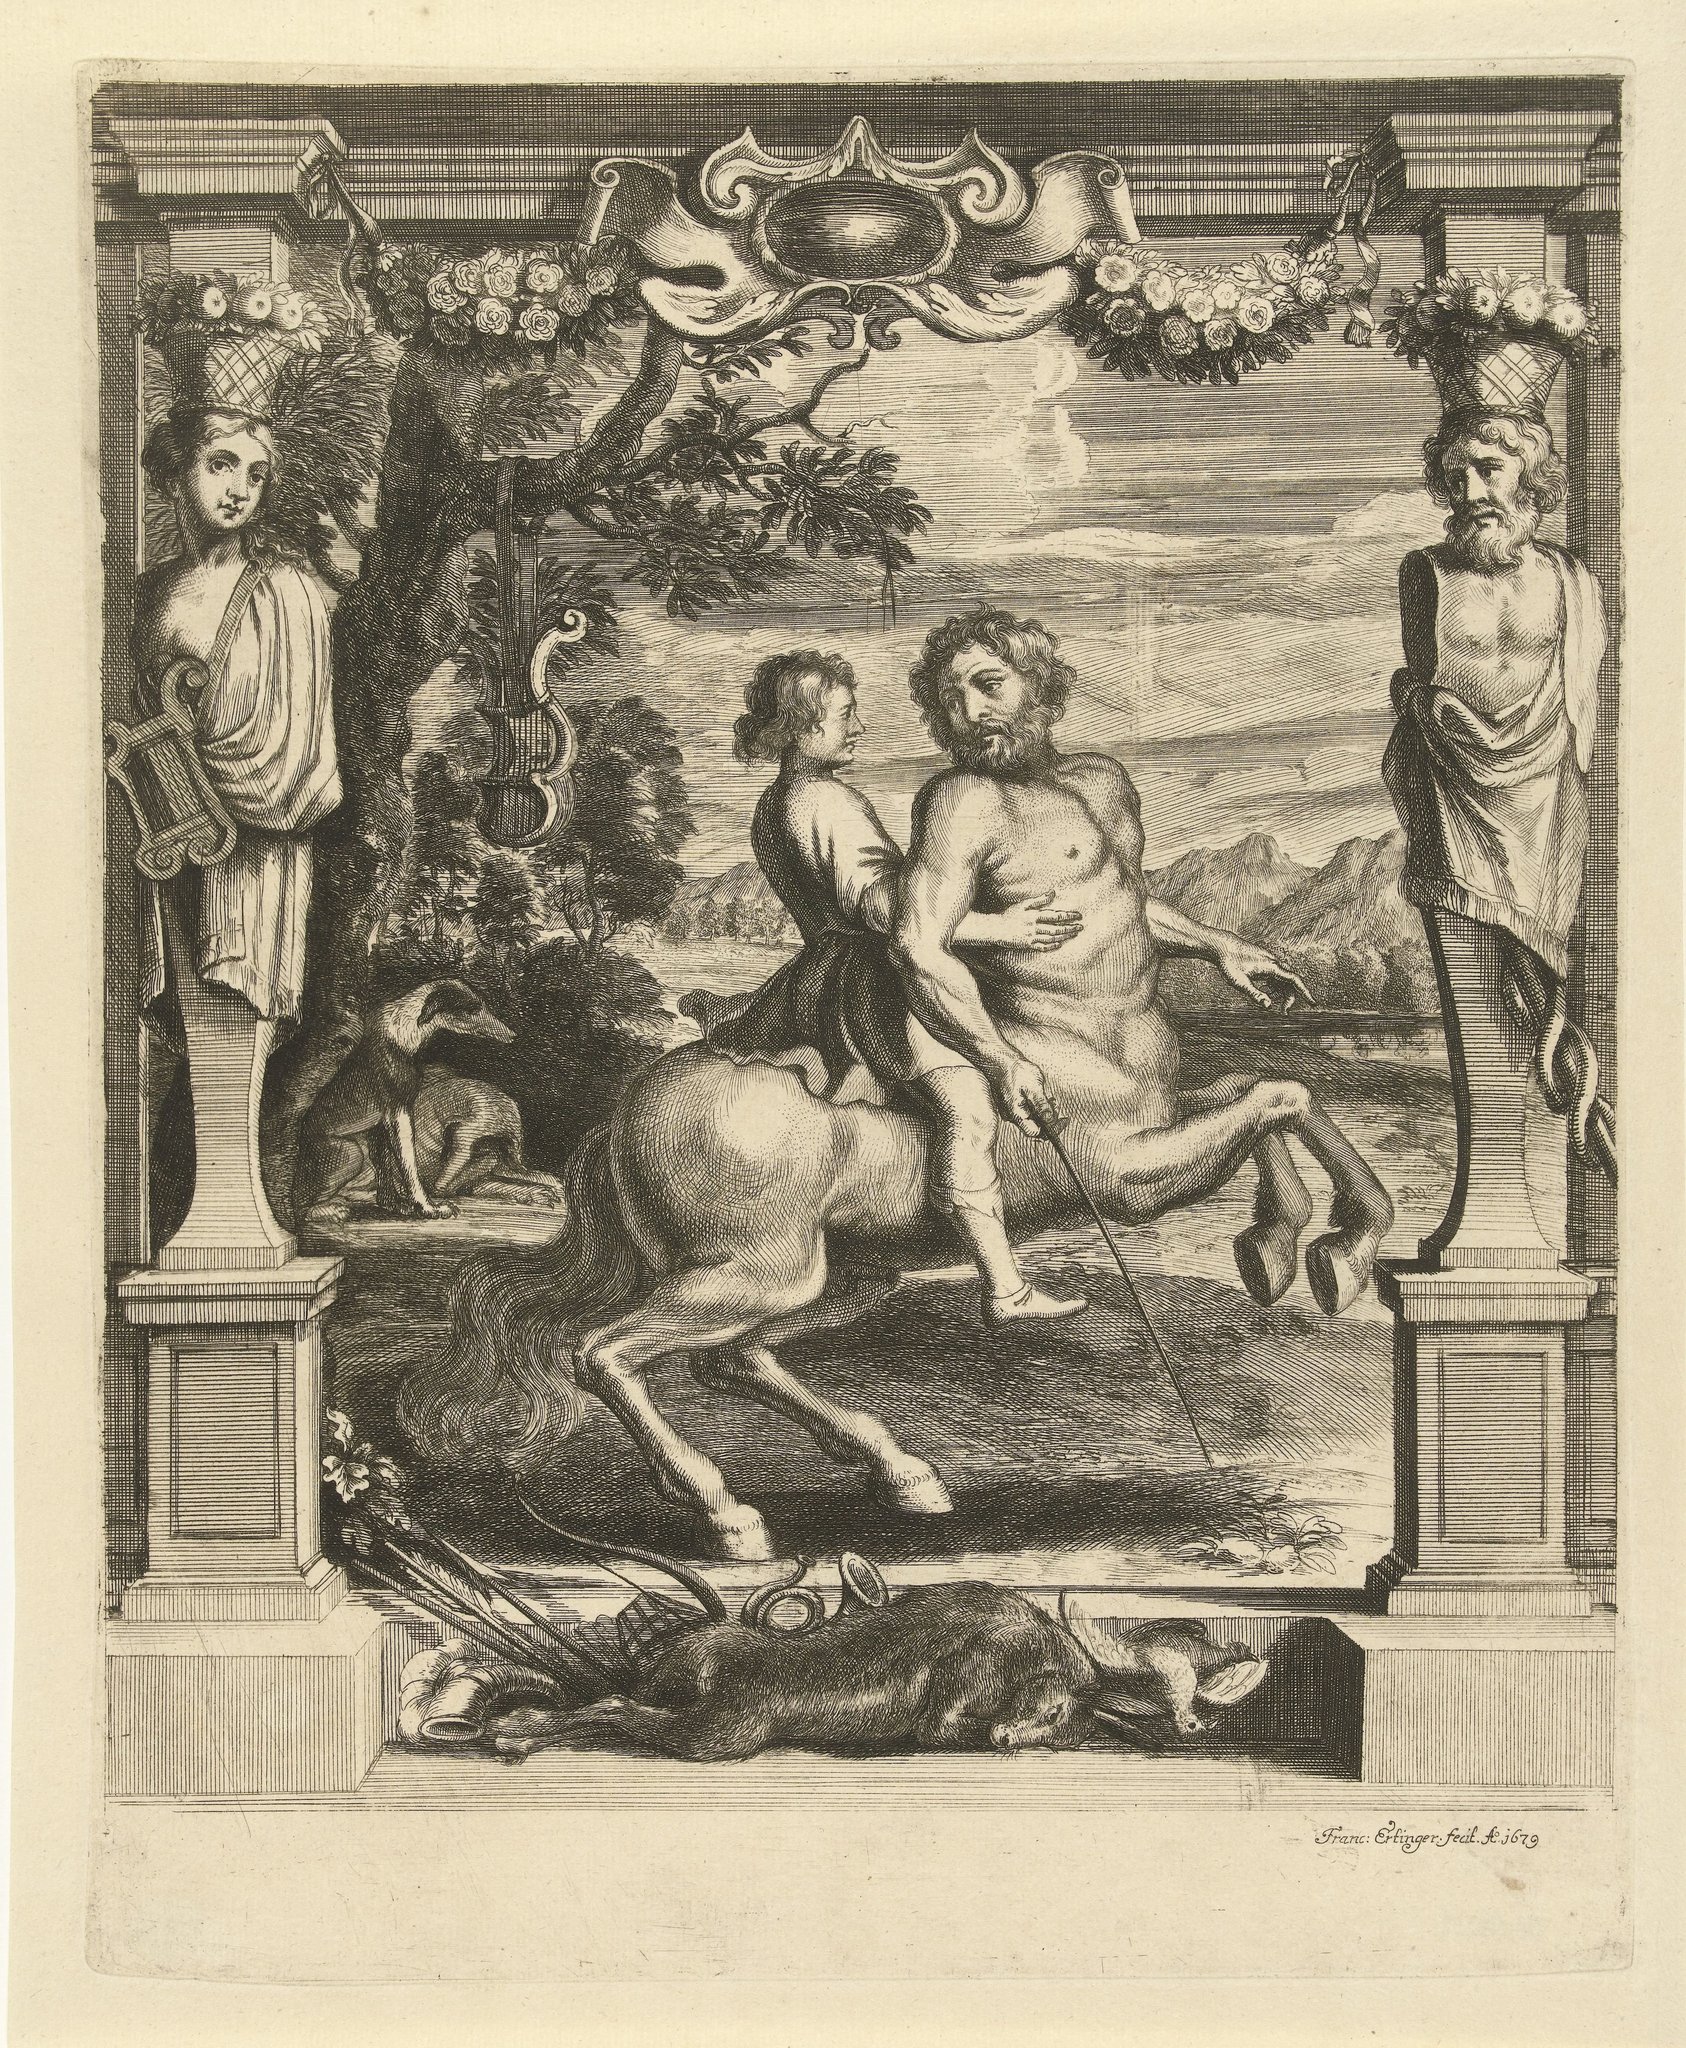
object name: print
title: Achilles onderwezen door Chiron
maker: franz ertinger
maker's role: print maker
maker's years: 1640-1710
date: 1679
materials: paper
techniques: etching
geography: antwerp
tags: thetis hands achilles over to chiron, the centaur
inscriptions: collector's mark: Lugt 240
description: Achilles zit op de rug van de centaur Chiron. Op de achtergrond honden onder een boom waar een lier aan hangt. Op de voorgrond een Caryatide en Atalant en geschoten wild.